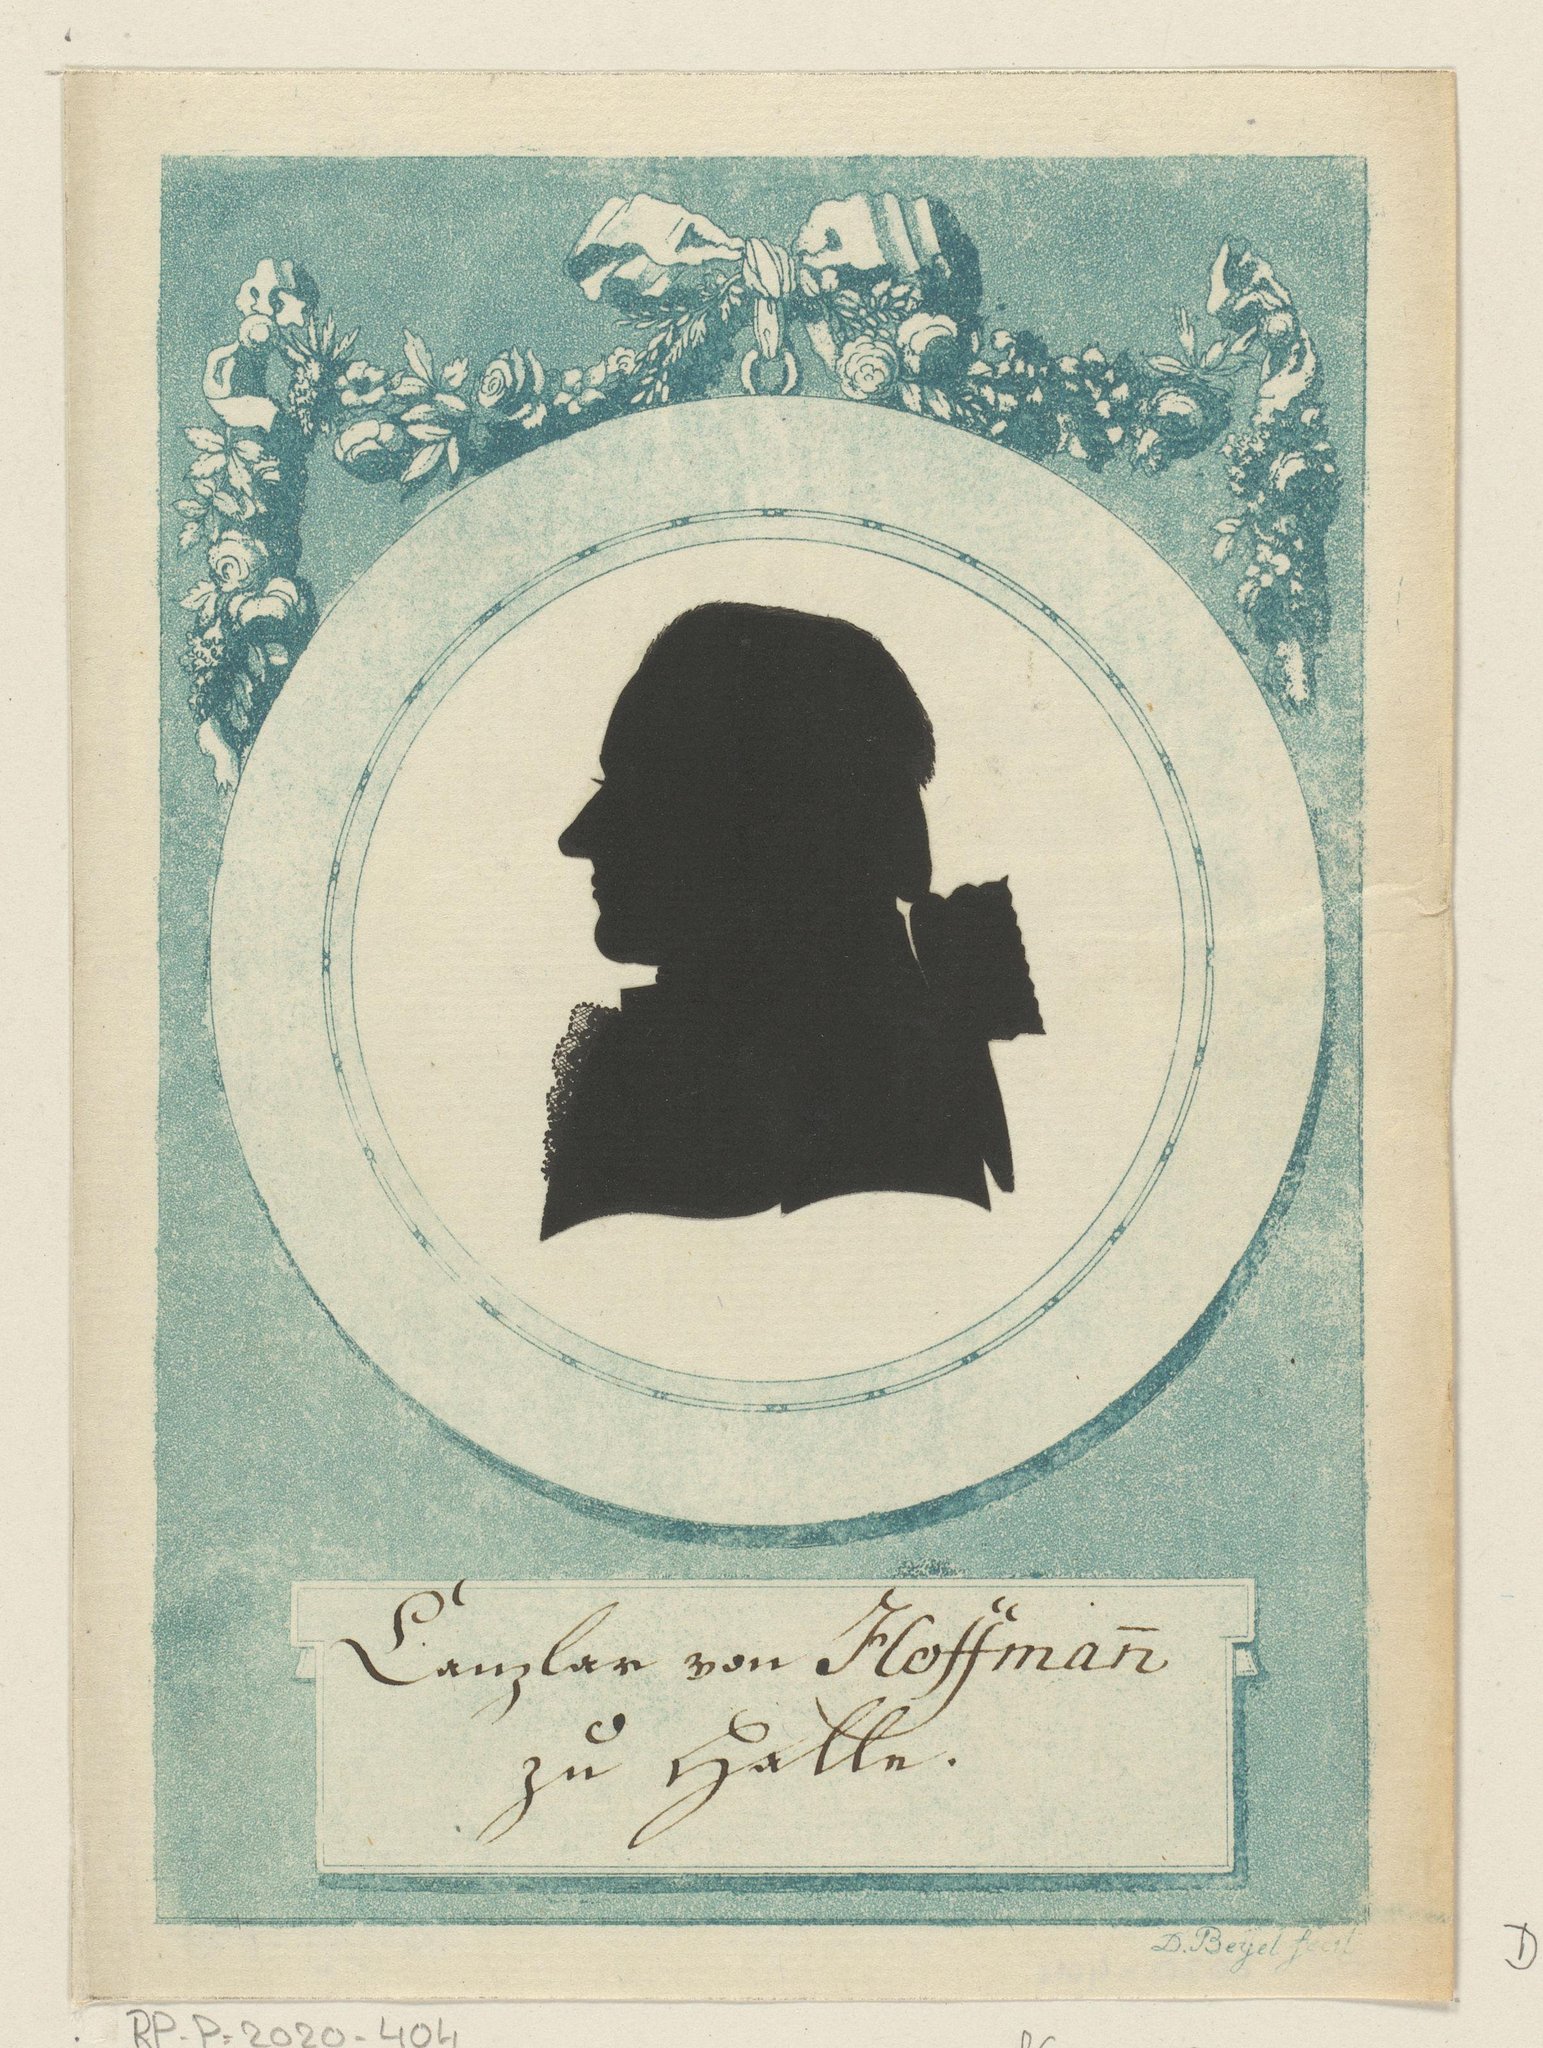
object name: silhouette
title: Silhouetportret van Carl Christoph von Hoffmann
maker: daniel beyel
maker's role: draughtsman, print maker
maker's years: 1760-1823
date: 1785-1799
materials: ink, paper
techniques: aquatint, etching, pen, snipping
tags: berlin, historical persons